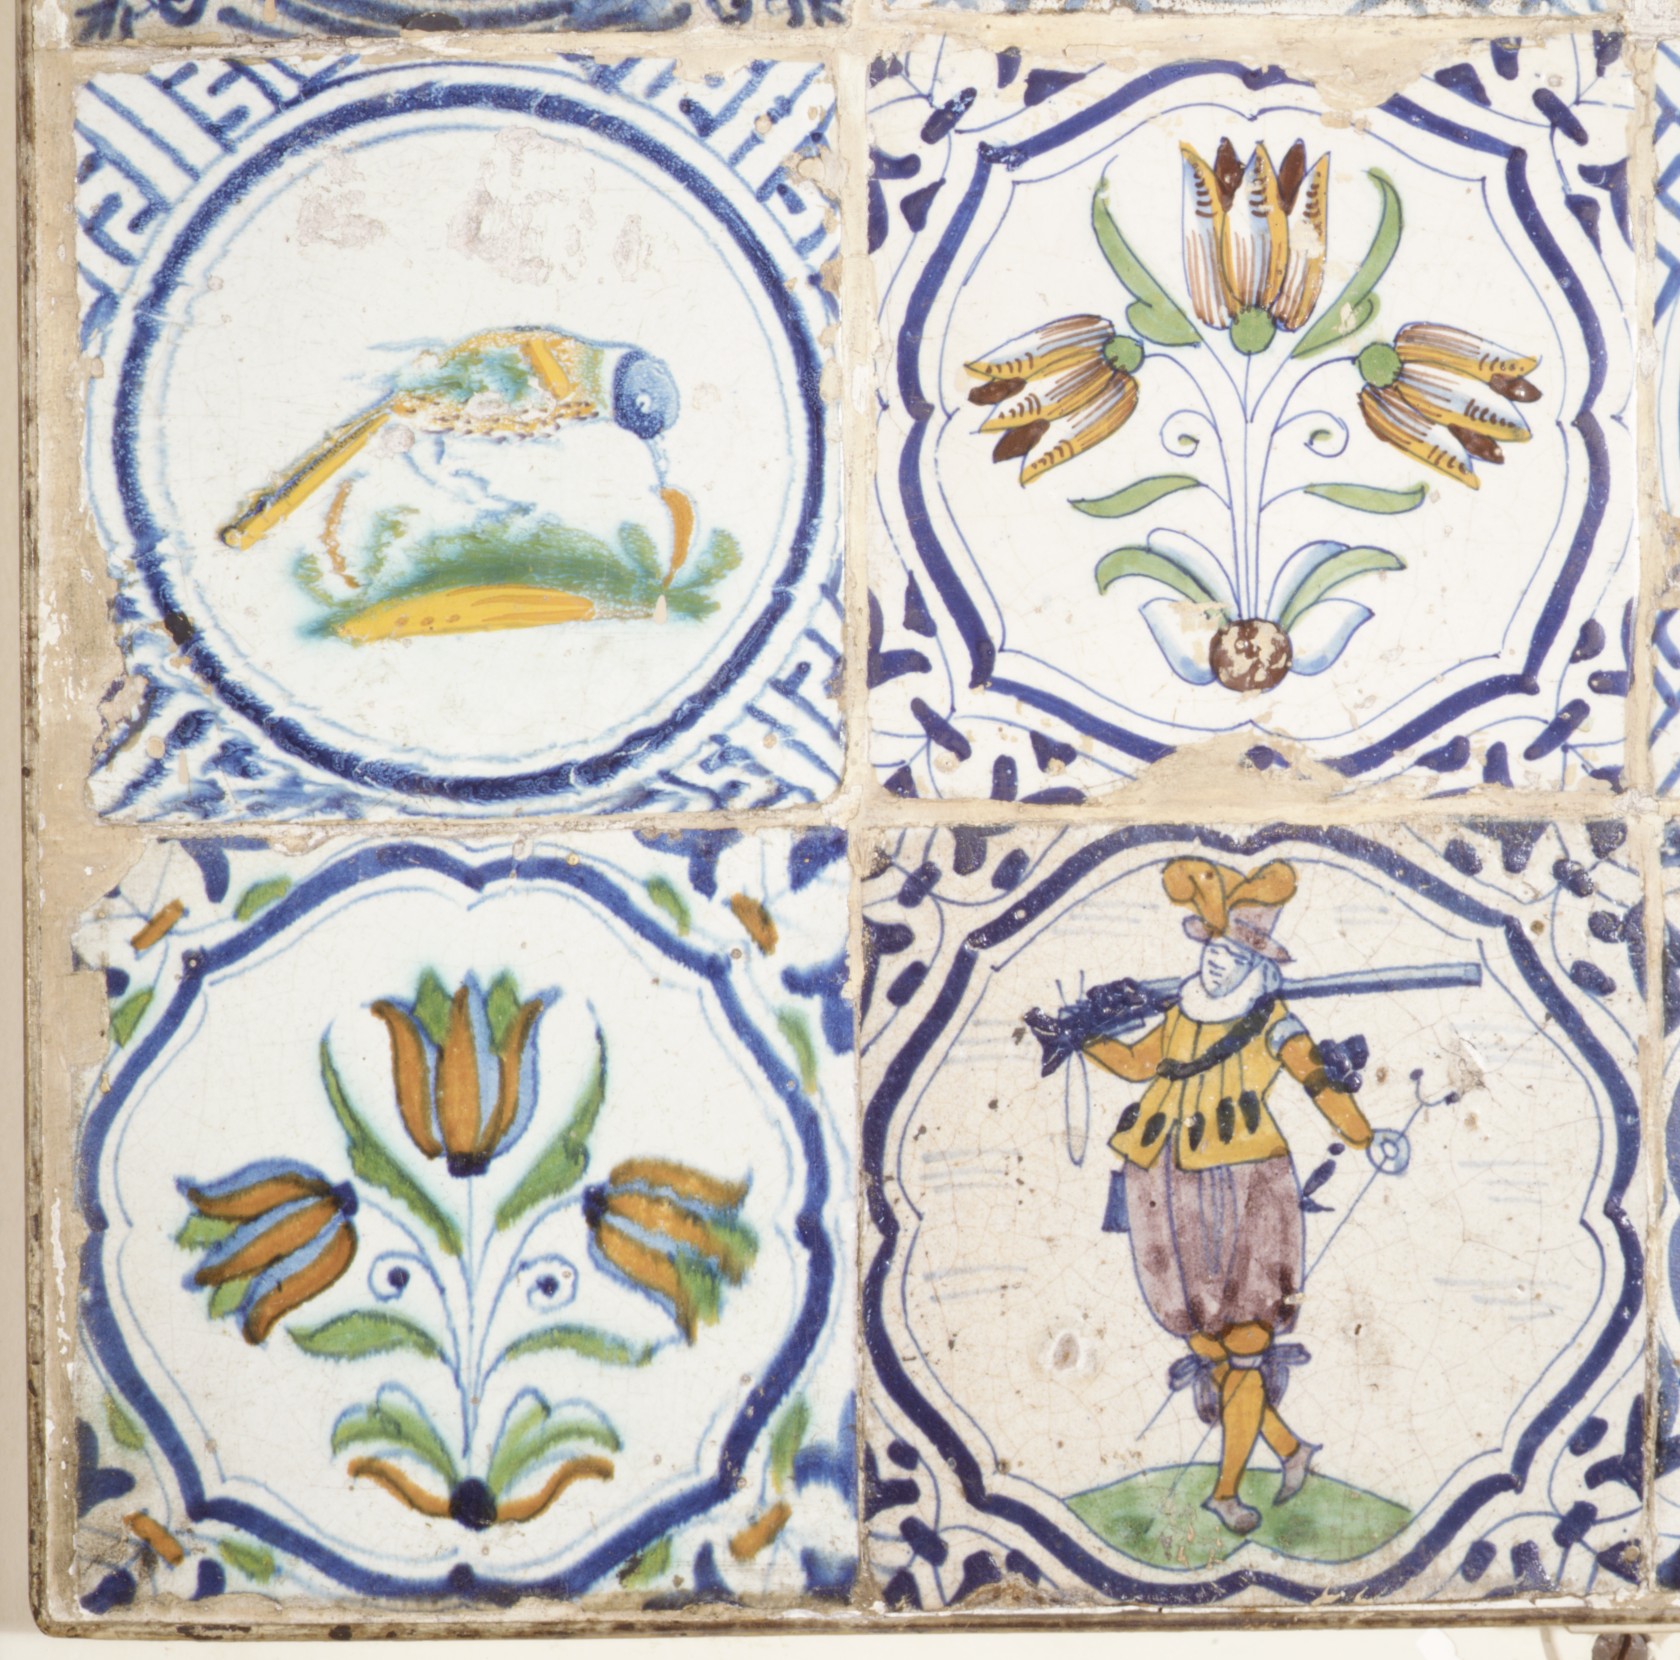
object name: tile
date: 1601-1700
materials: earthenware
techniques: glazing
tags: birds,firearms,men,flowers